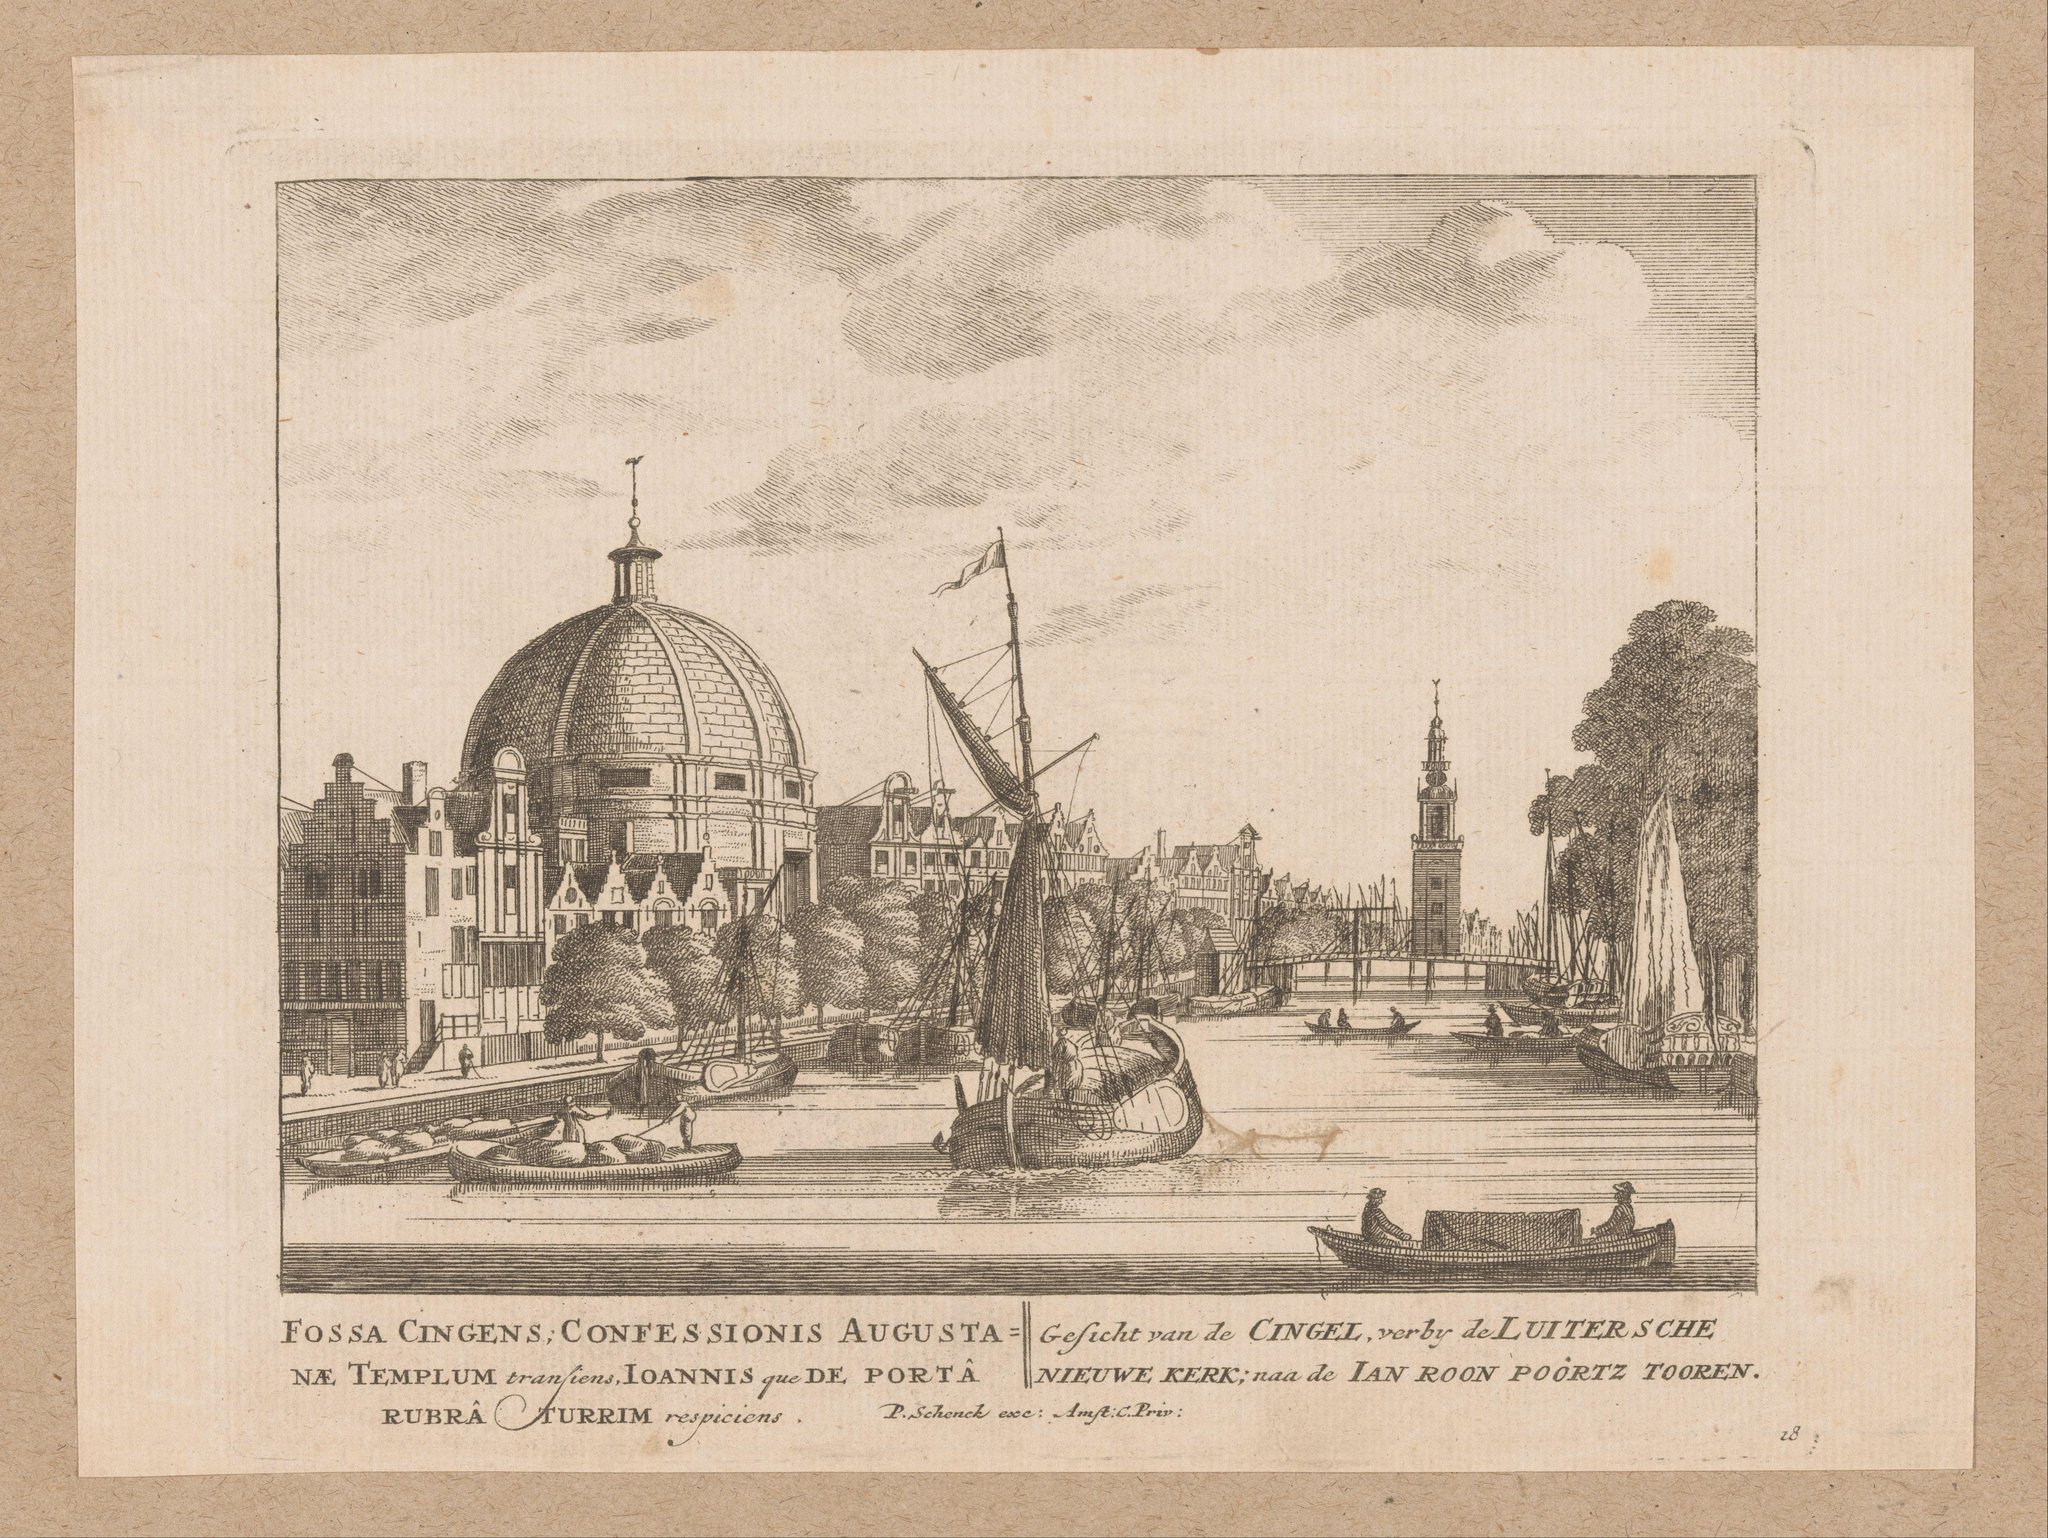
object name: print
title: Fossa Cingens; Confessionis Augustana=nae Templum transiens, Joannis que De porta Rubrâ turrim respiciens / Gesicht van de Cingel, verbij de Luitersche Nieuwe Kerk; naa de Jan Roon Poortz tooren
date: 1680-1700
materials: paper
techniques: etching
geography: amsterdam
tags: canals, waters (in city), amsterdam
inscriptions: watermark